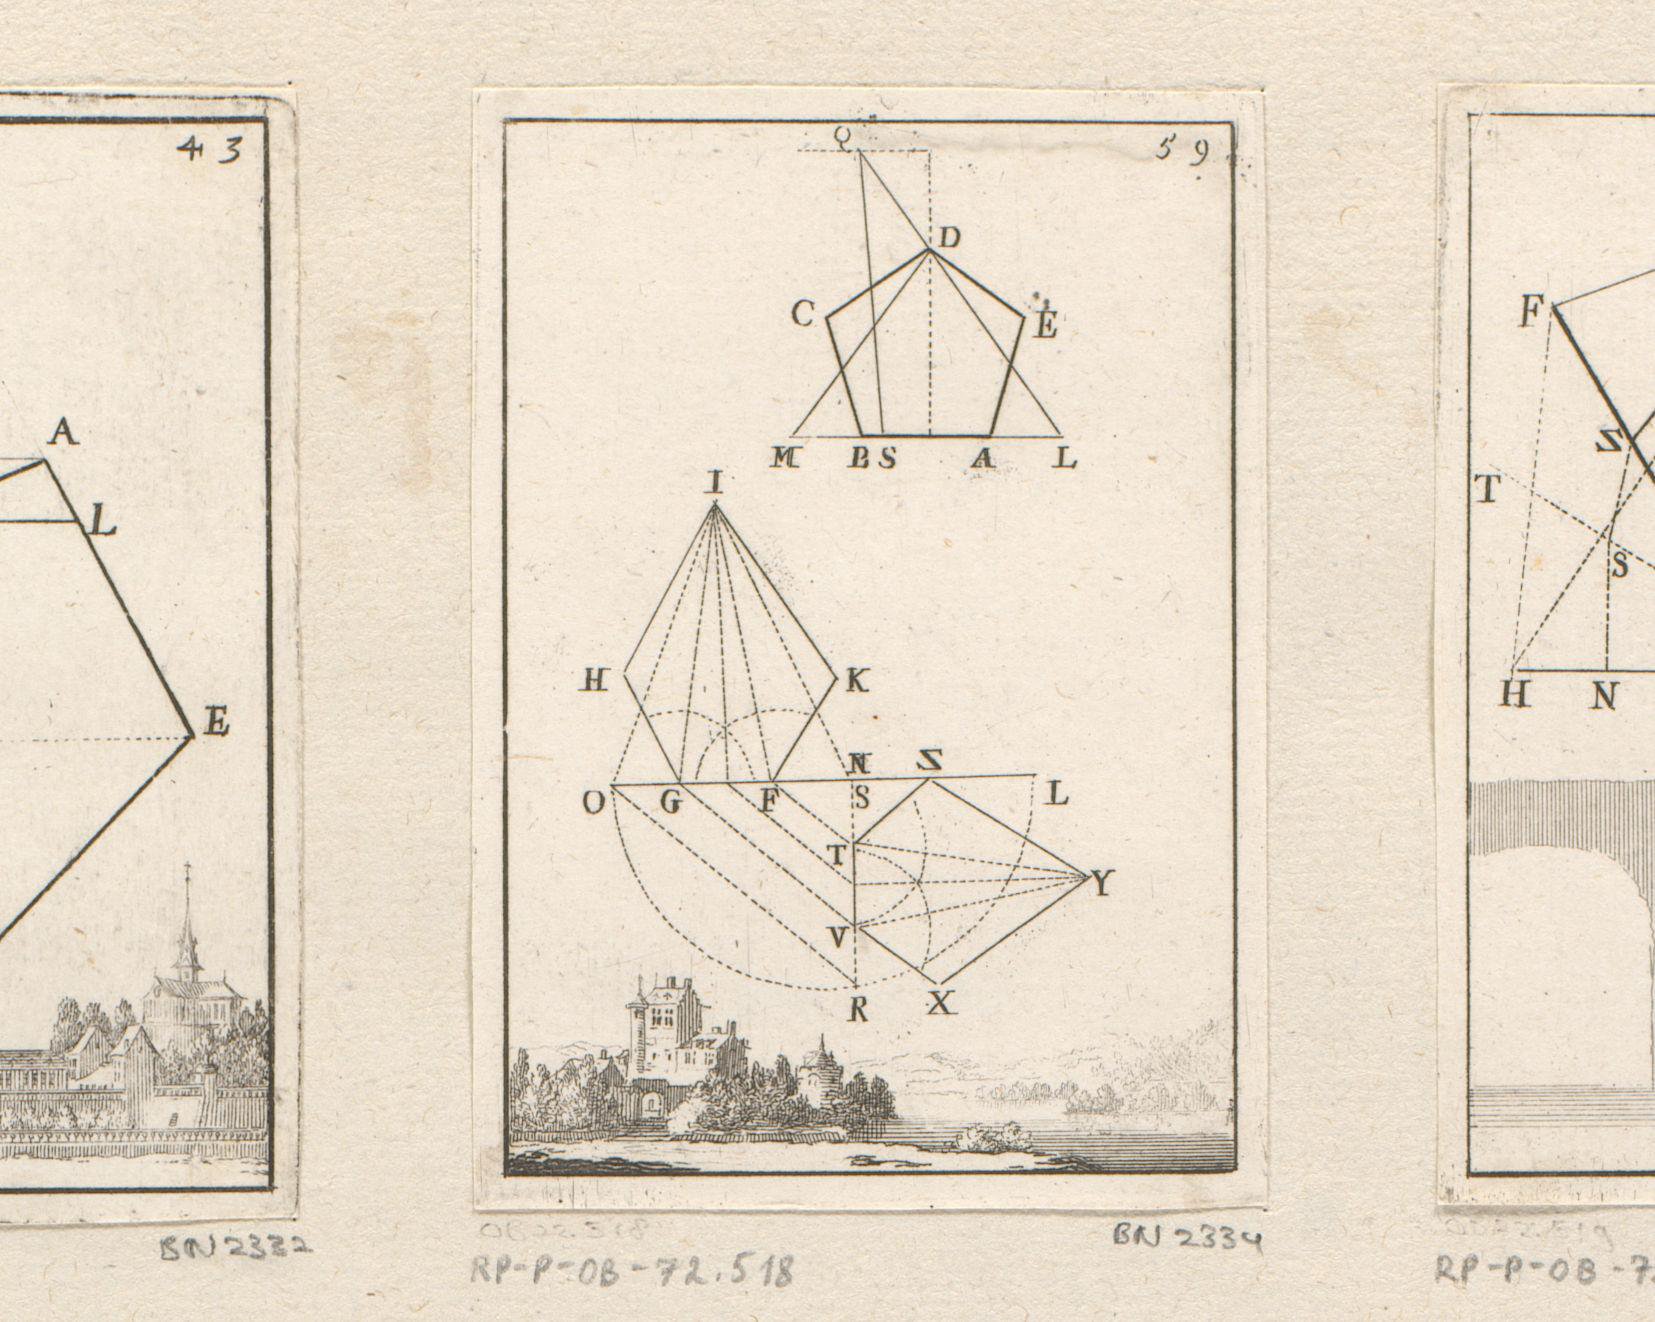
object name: book illustration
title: Vijfhoek teruggebracht tot een driehoek met onderaan zicht op een vestiging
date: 1669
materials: paper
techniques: etching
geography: france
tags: castle, planimetry, geometry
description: Prent toegevoegd aan: Pratique de la géometrie, sur le papier et sur le terrain. Avec un nouvel ordre et une méthode particulière. Parijs: Thomas Jolly, 1669.